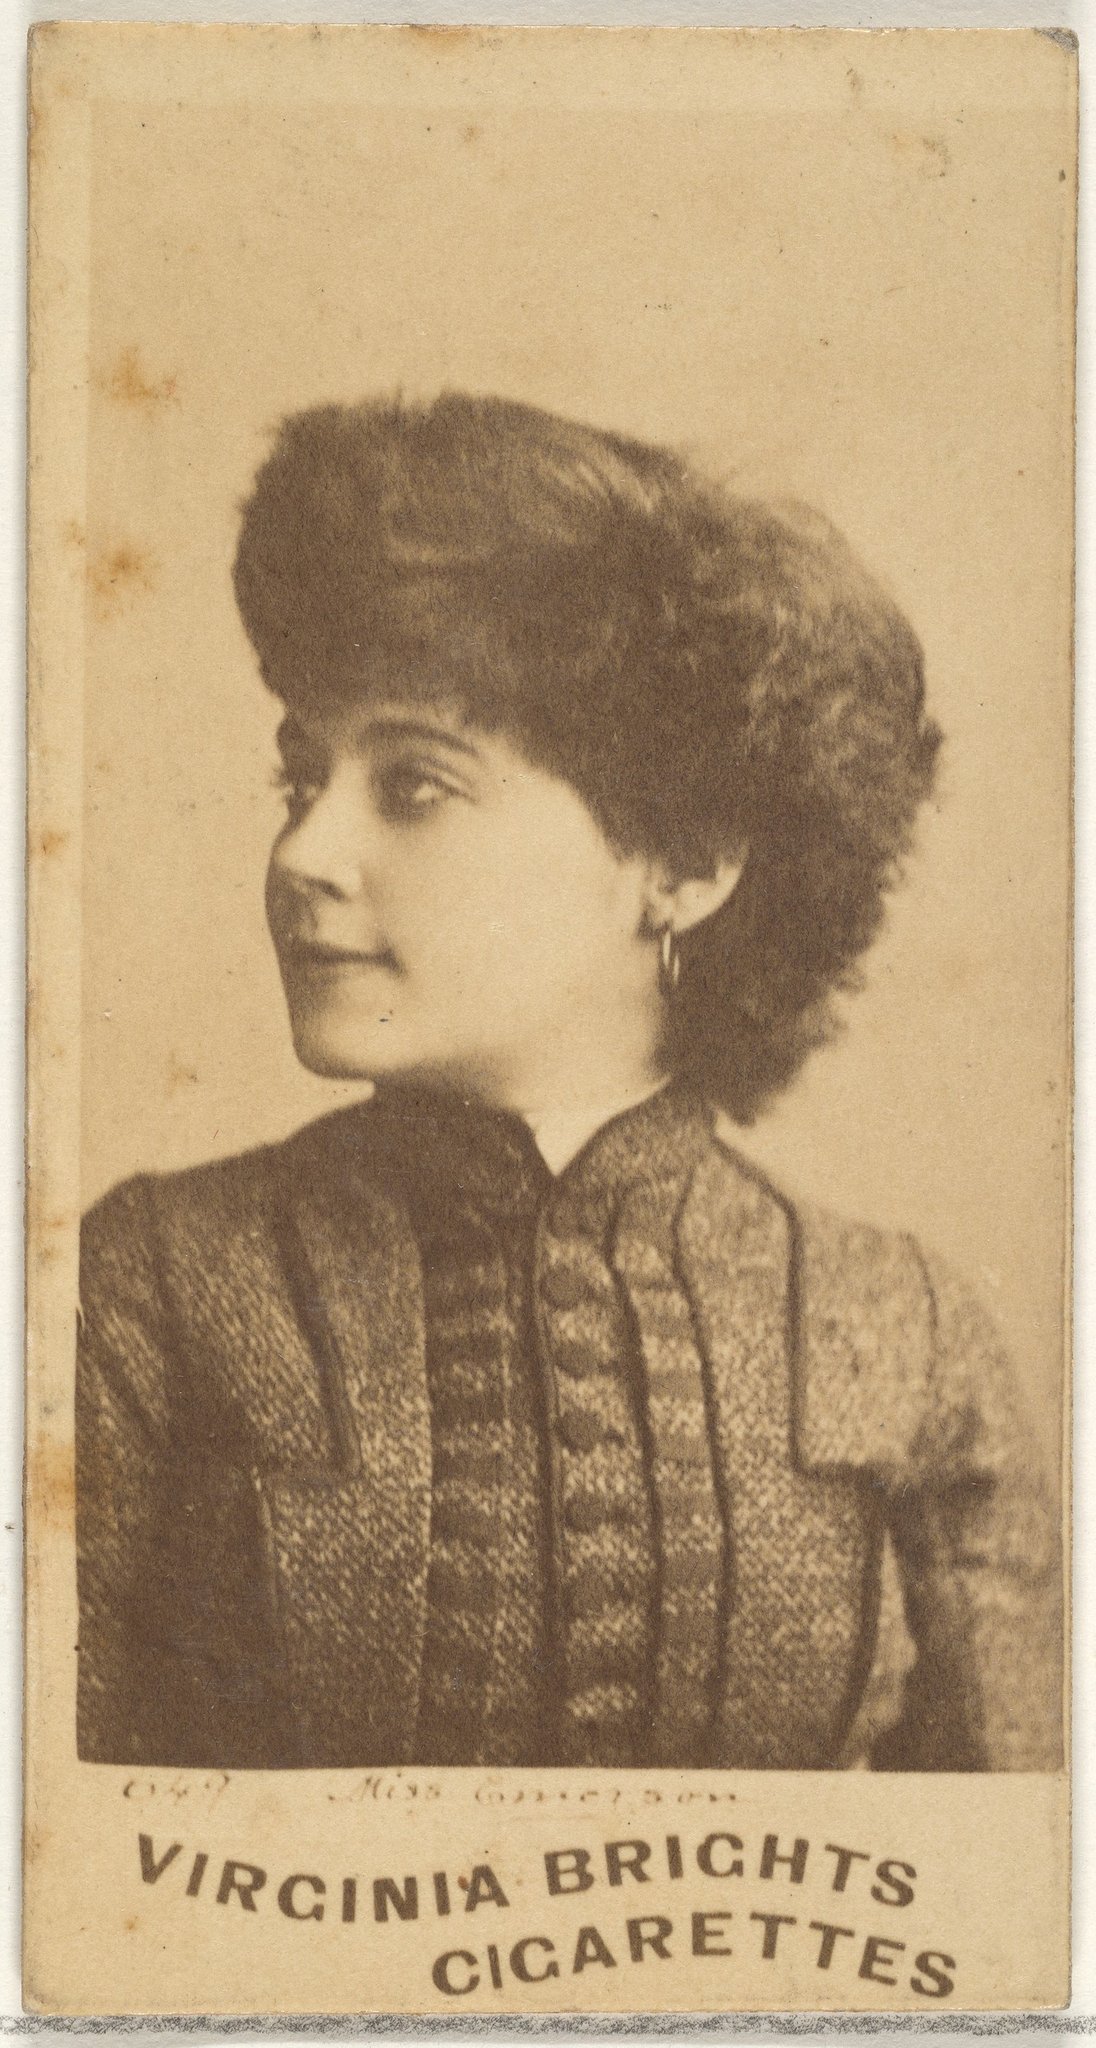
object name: photograph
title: Card 649, Miss Emerson, from the Actors and Actresses series (N45, Type 1) for Virginia Brights Cigarettes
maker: allen & ginter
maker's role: publisher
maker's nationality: american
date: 1888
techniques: albumen silver print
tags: portraits,women,actresses